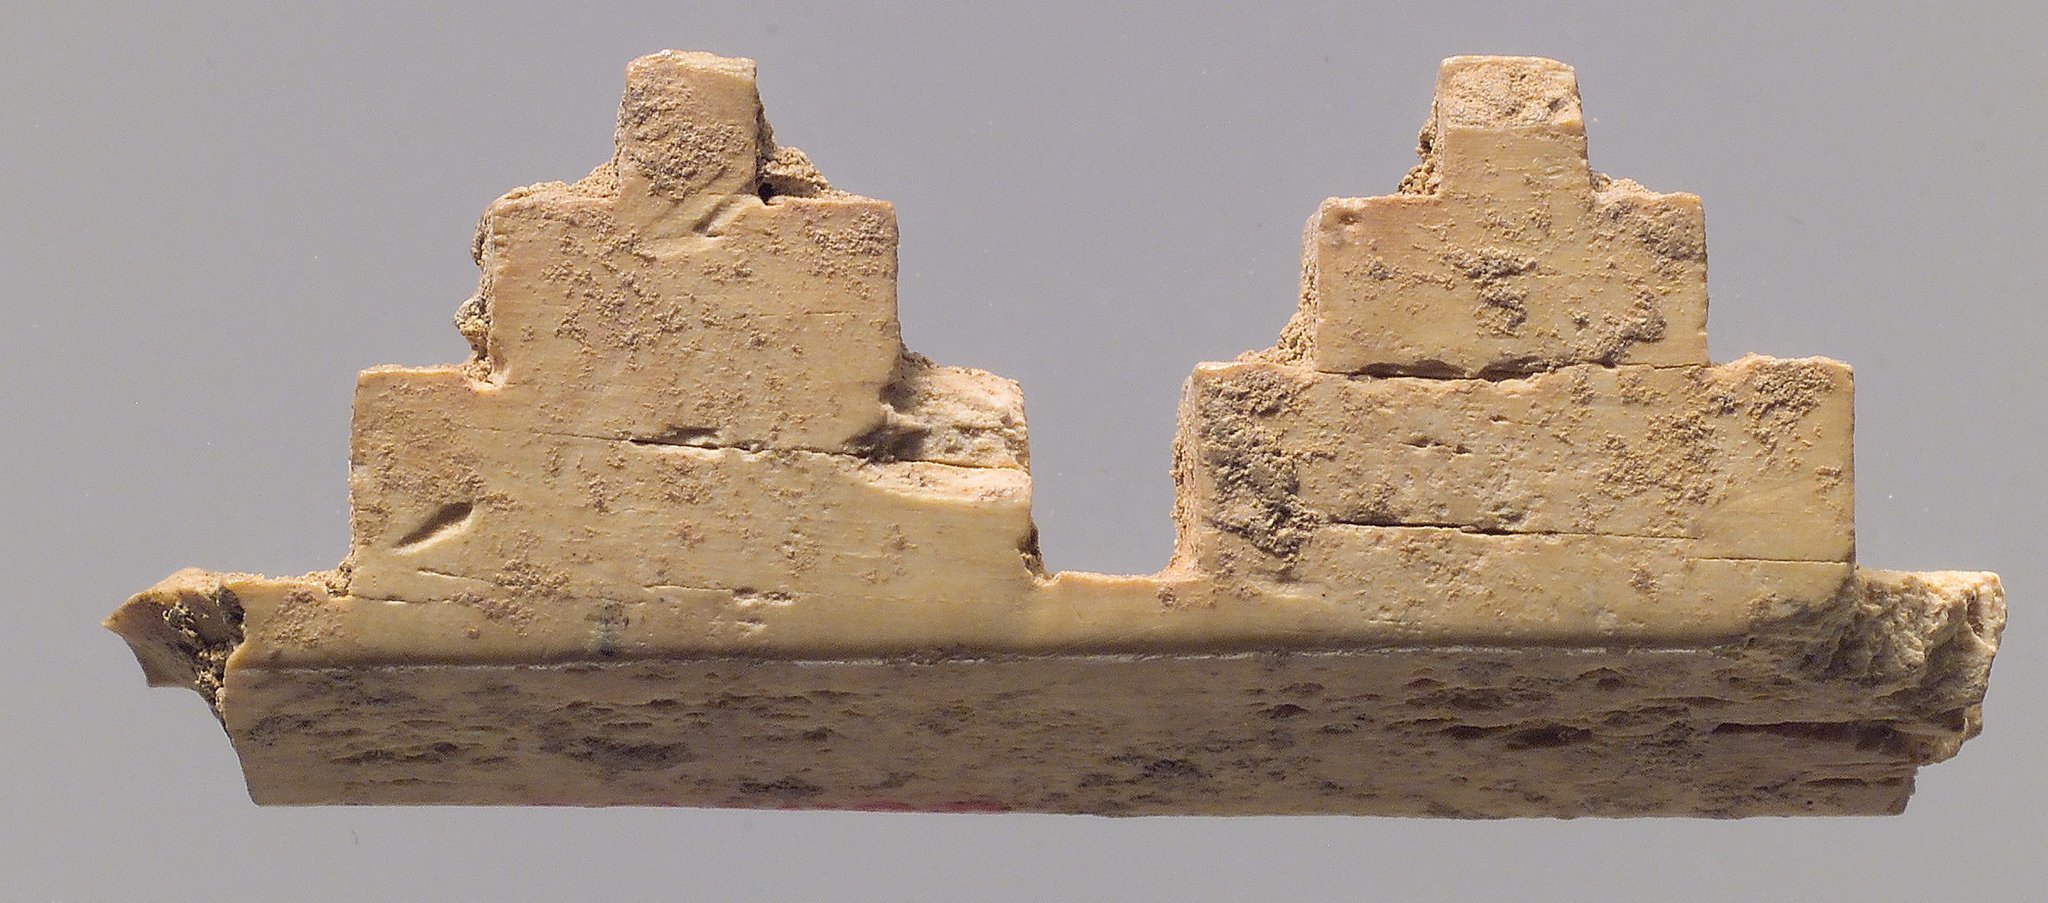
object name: ornament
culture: iranian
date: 800-601 BCE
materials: bone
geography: iran